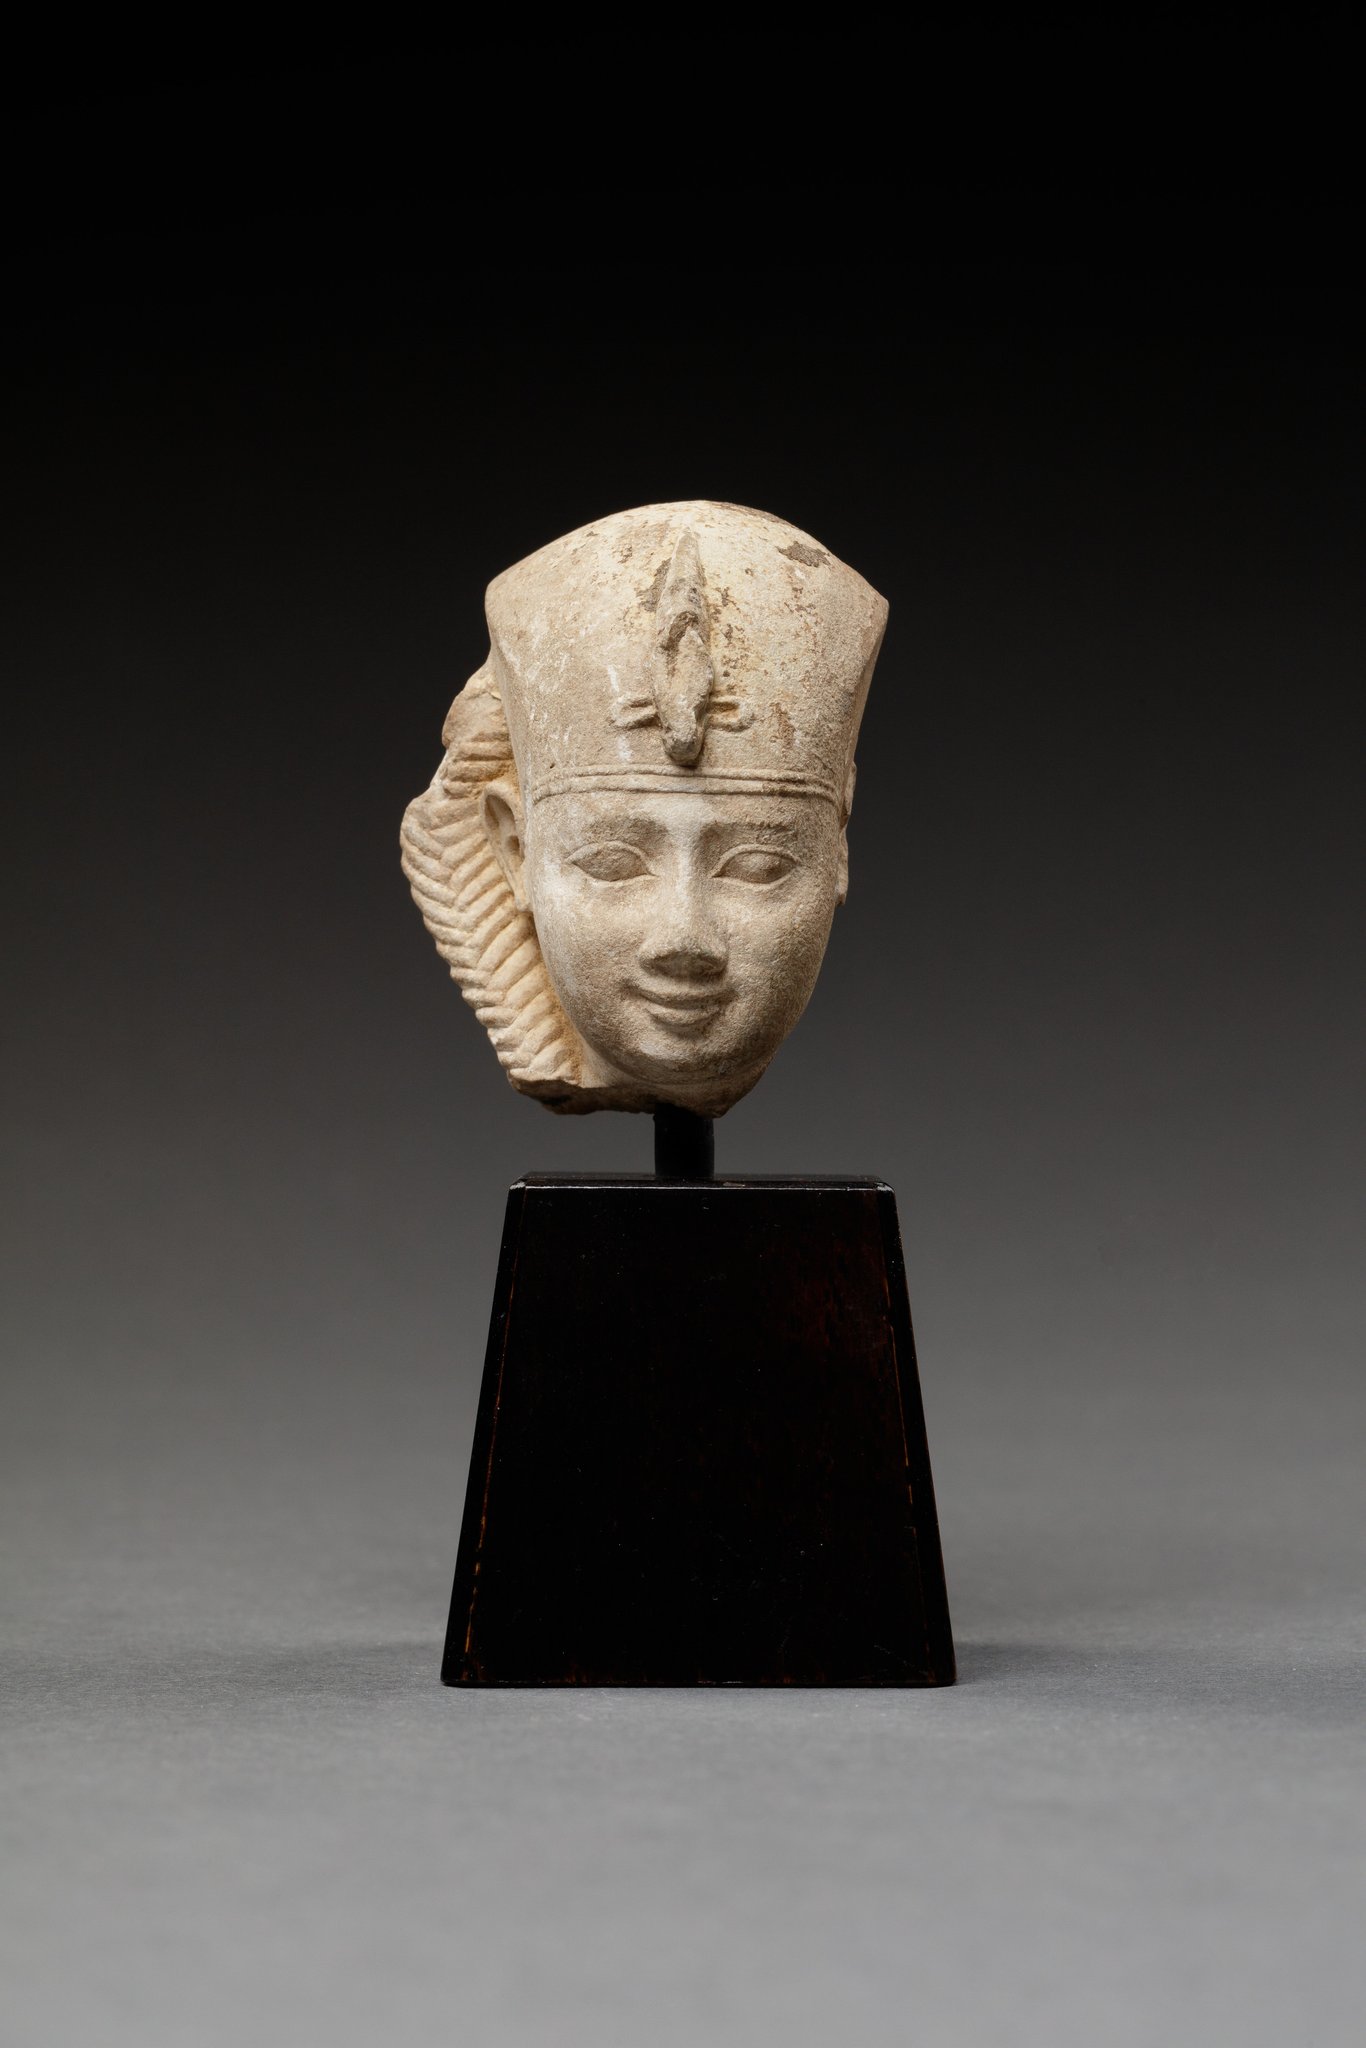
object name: head of a harpokrates with a blue crown and sidelock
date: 332-330 BCE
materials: limestone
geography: egypt